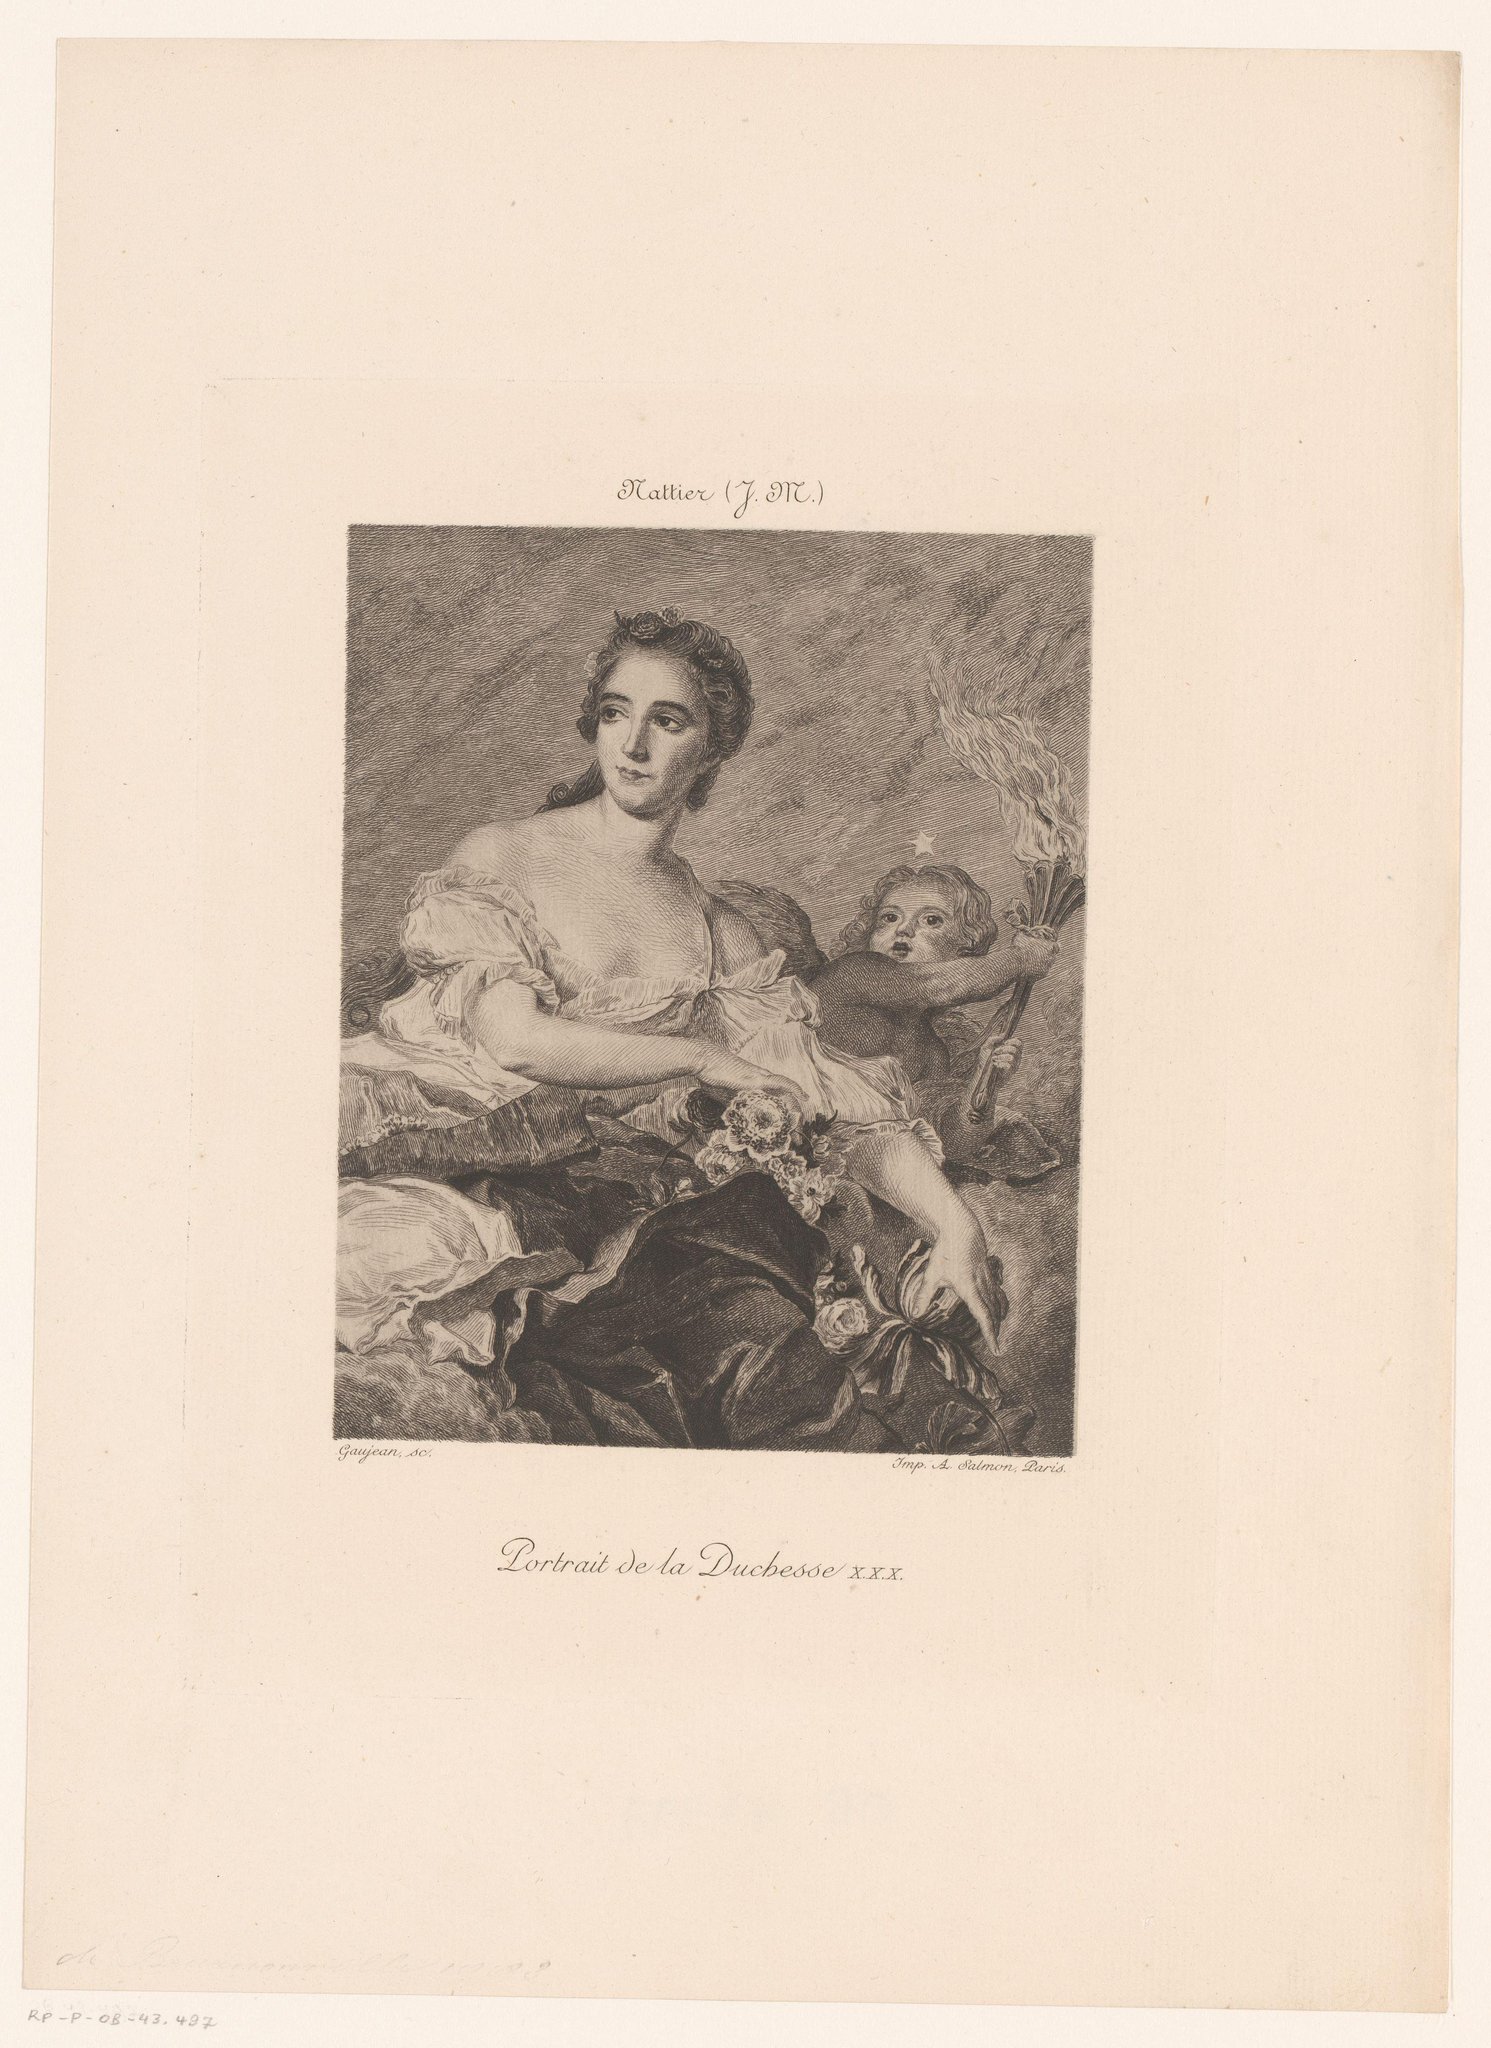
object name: print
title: Serie prenten naar schilderijen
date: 1860-1900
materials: paper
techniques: drypoint, engraving, etching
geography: france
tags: triumph of aurora: in her chariot drawn by two (sometimes four) horses, and possibly scattering flowers; aurora's victory over the night; 'carro dell'aurora' (ripa), historical persons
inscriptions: collector's mark: Lugt 2228